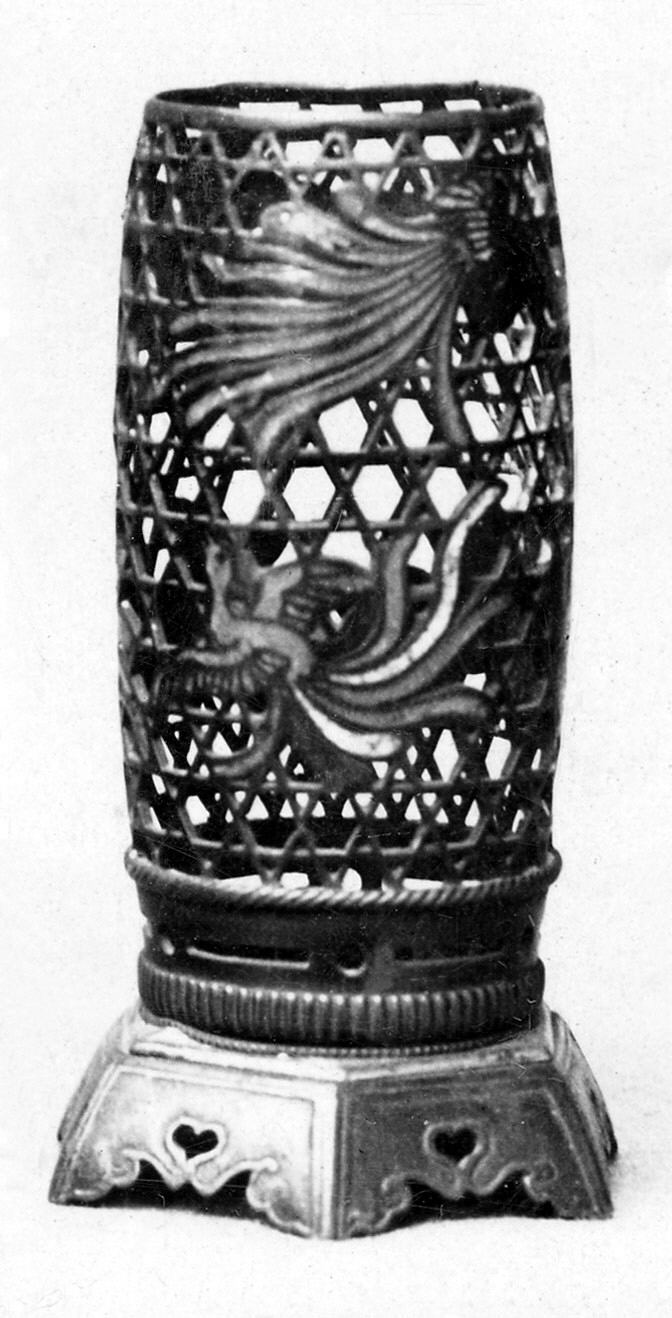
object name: brush holder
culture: japanese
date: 1701-1800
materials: bronze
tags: phoenix